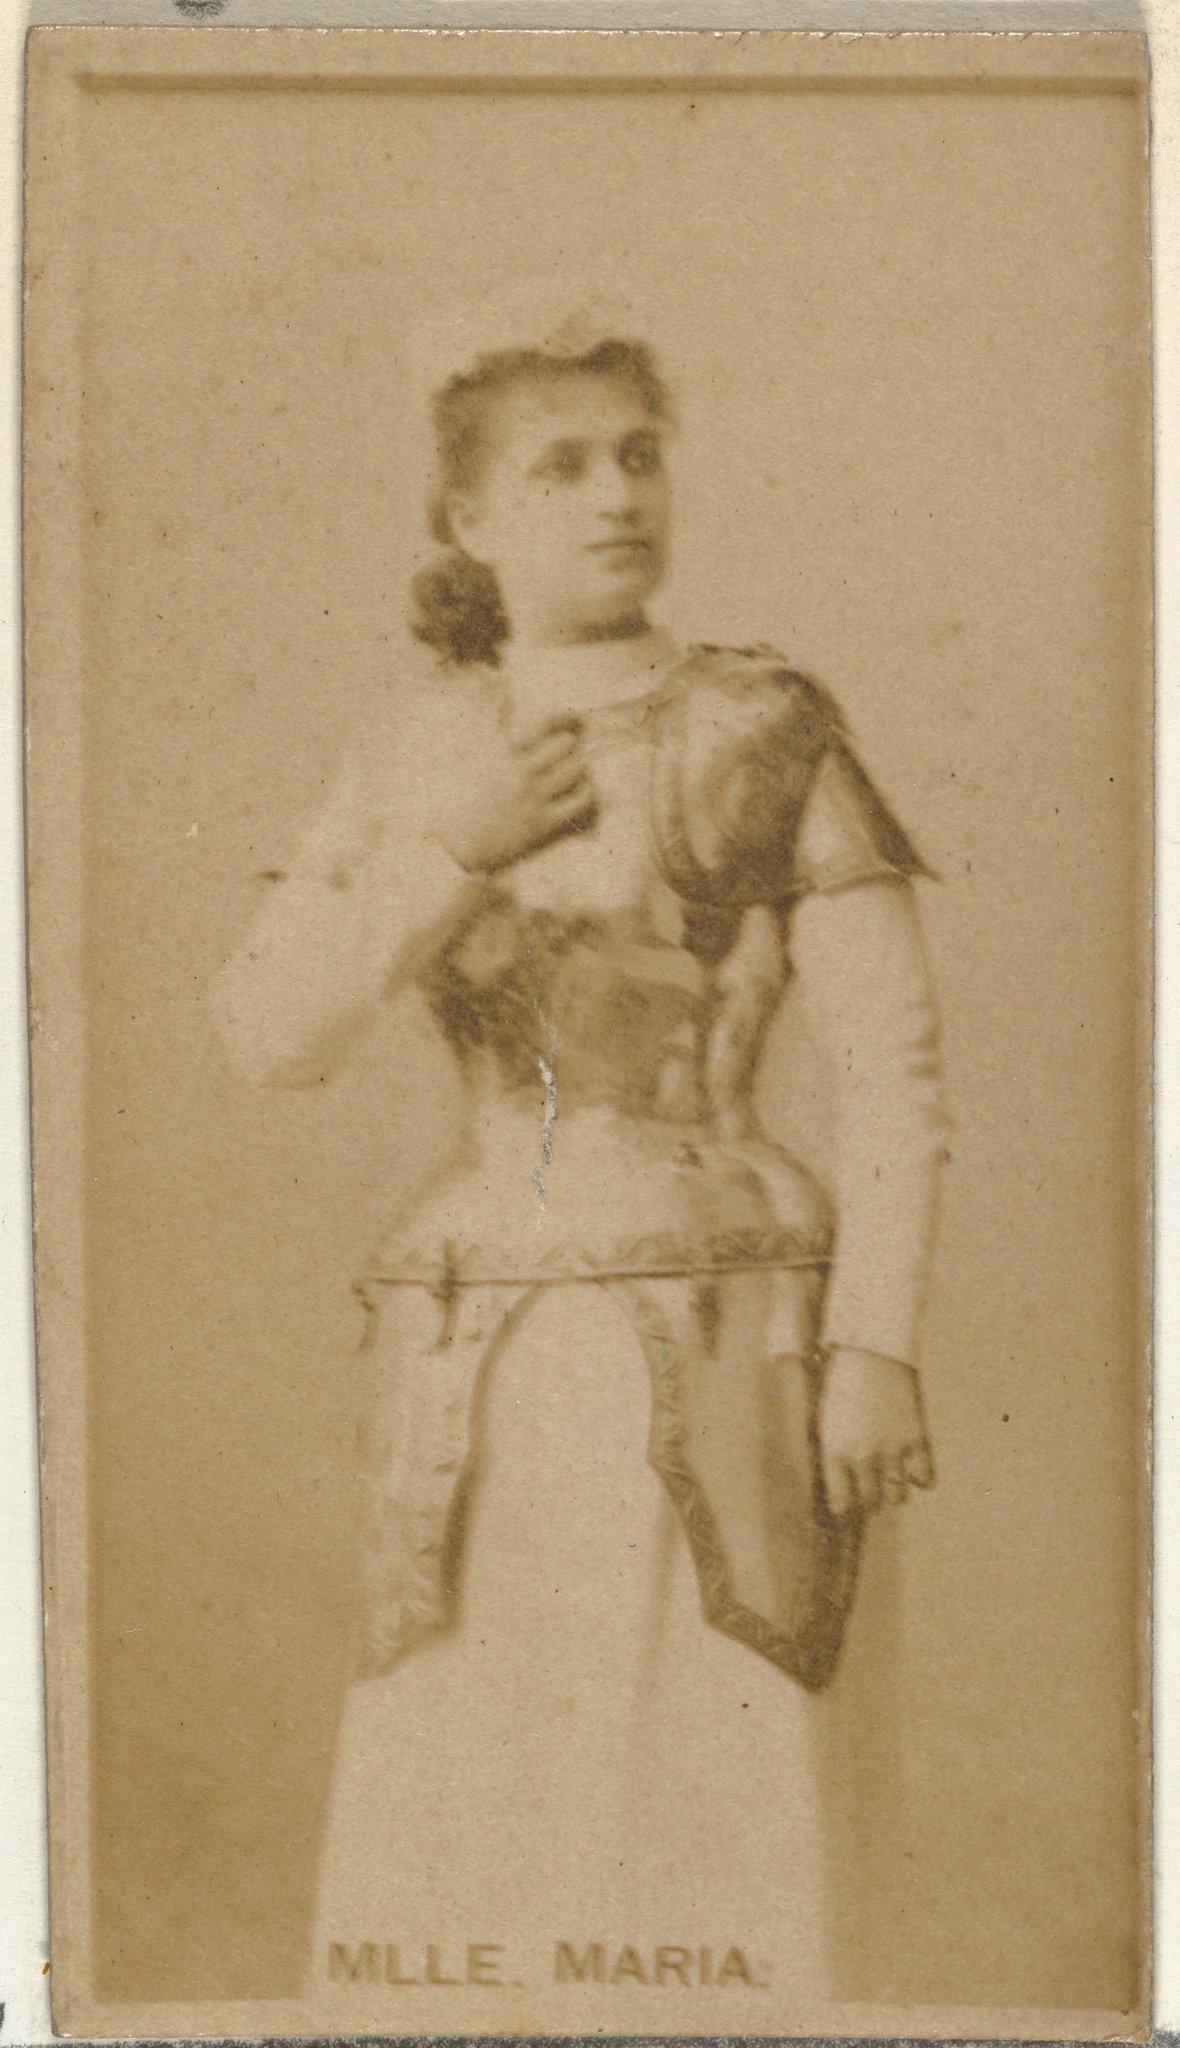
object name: photograph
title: Mlle. Maria, from the Actors and Actresses series (N145-8) issued by Duke Sons & Co. to promote Duke Cigarettes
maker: w. duke, sons & co.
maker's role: publisher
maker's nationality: american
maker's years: 1870-1920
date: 1891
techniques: albumen silver print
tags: portraits,women,actresses